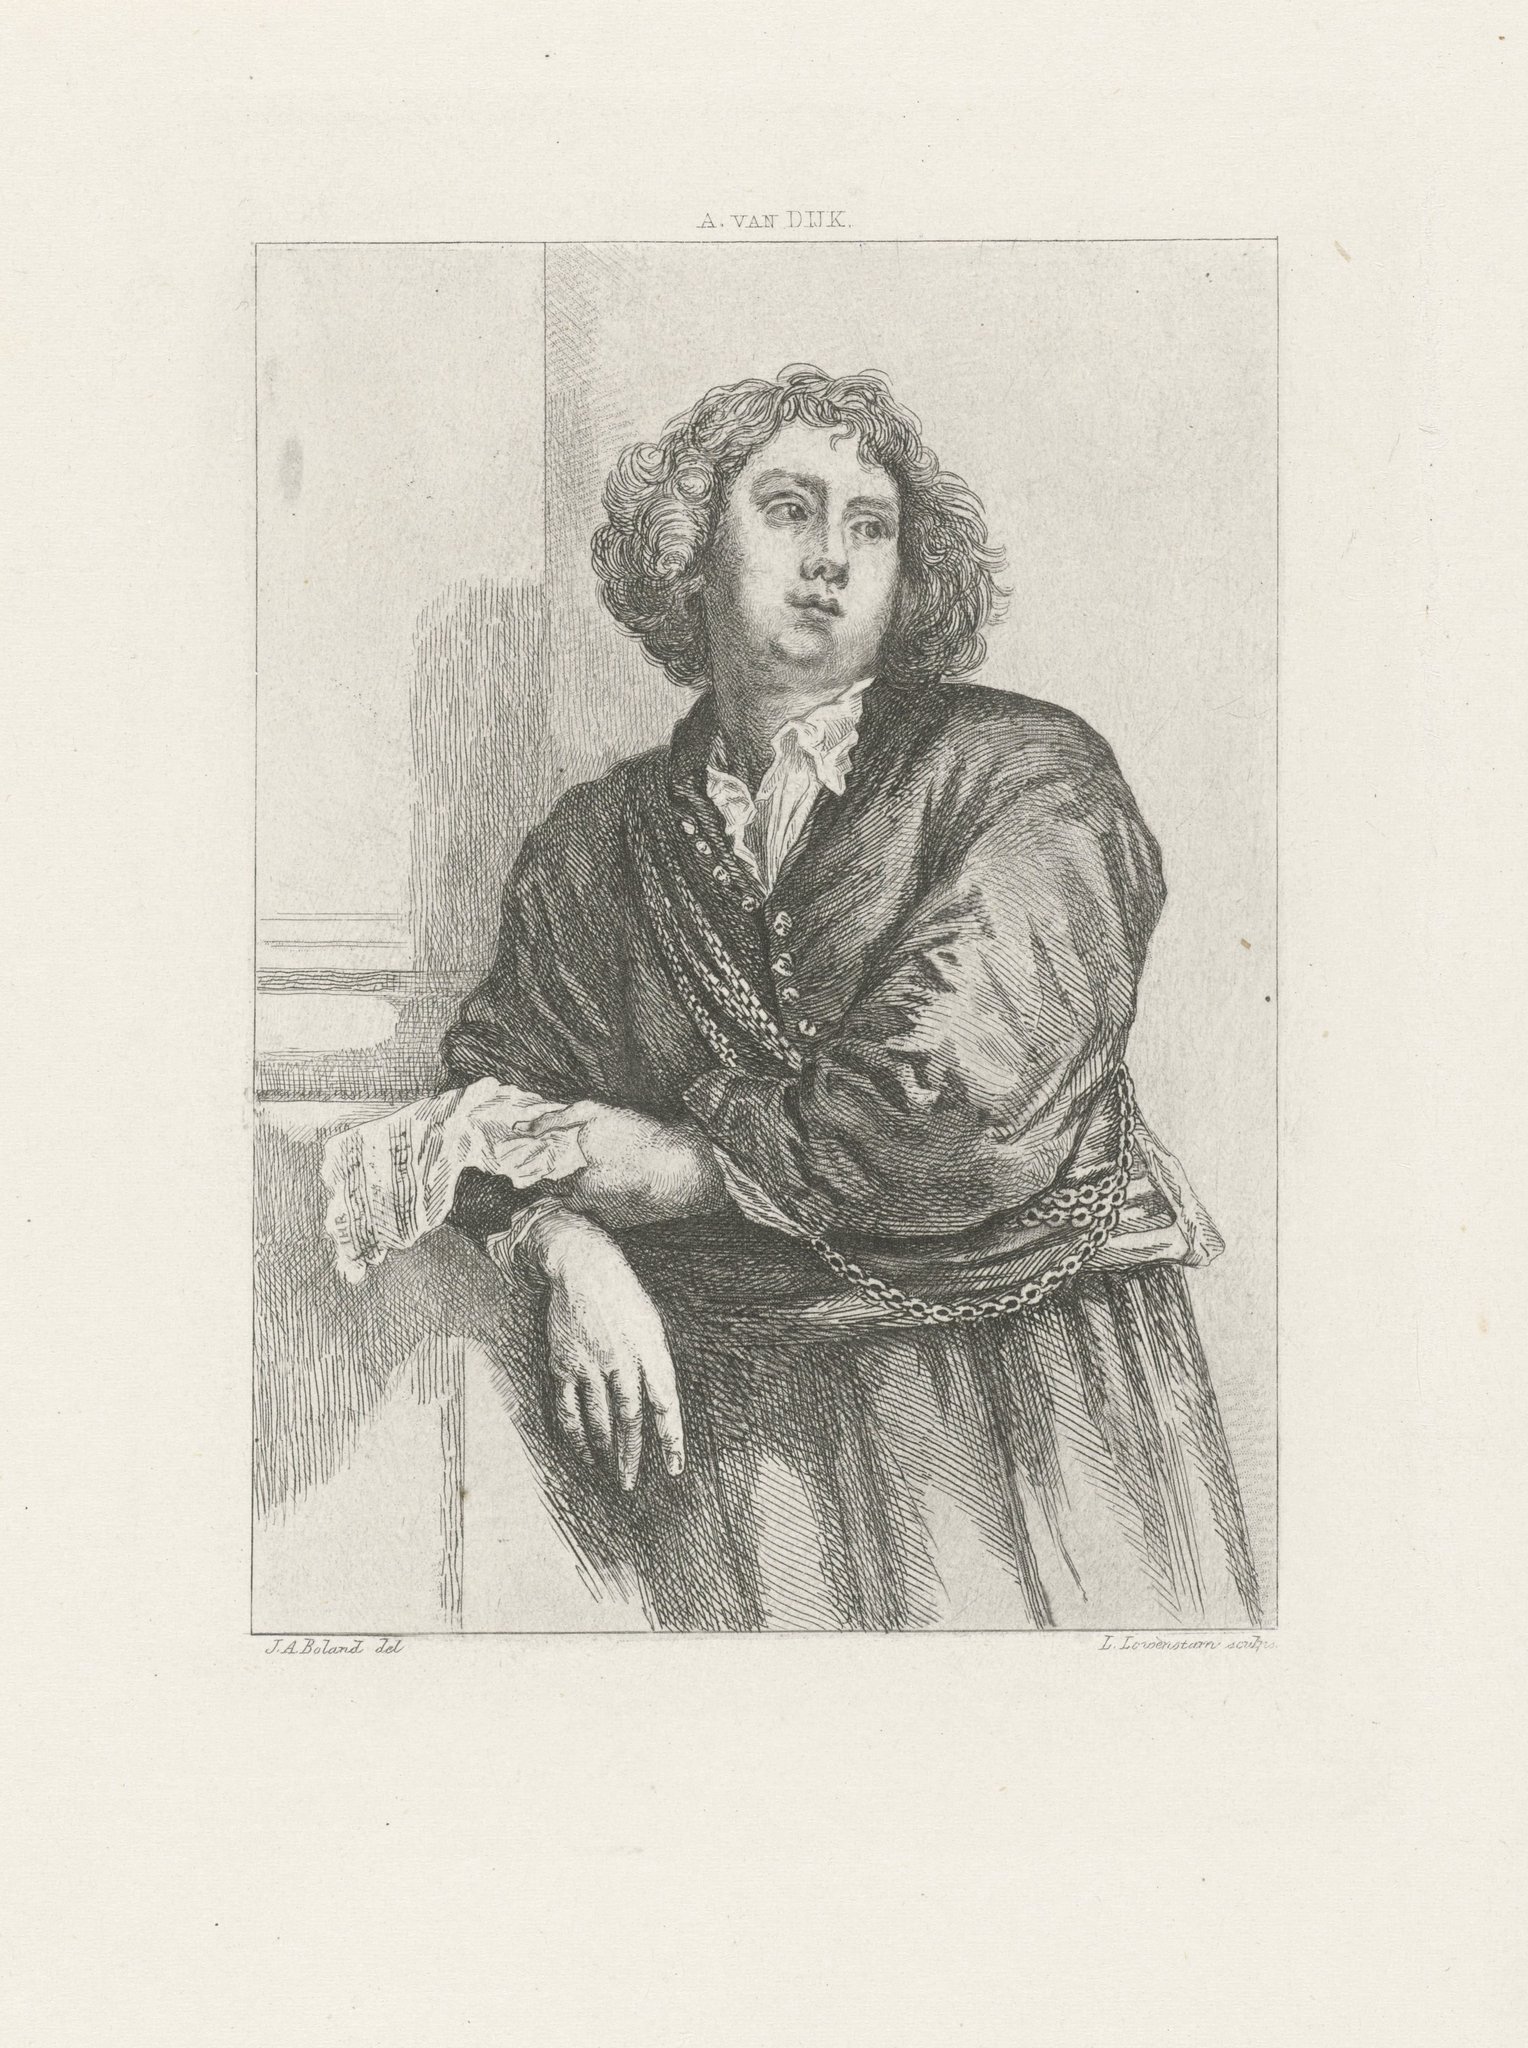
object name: print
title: Portret van Henricus Liberti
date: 1852-1898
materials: paper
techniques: etching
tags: antwerp, notation of music, male sex; man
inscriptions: collector's mark: Lugt 2228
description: Portret van Henricus Liberti, leunend tegen de wand, met bladmuziek in zijn hand.